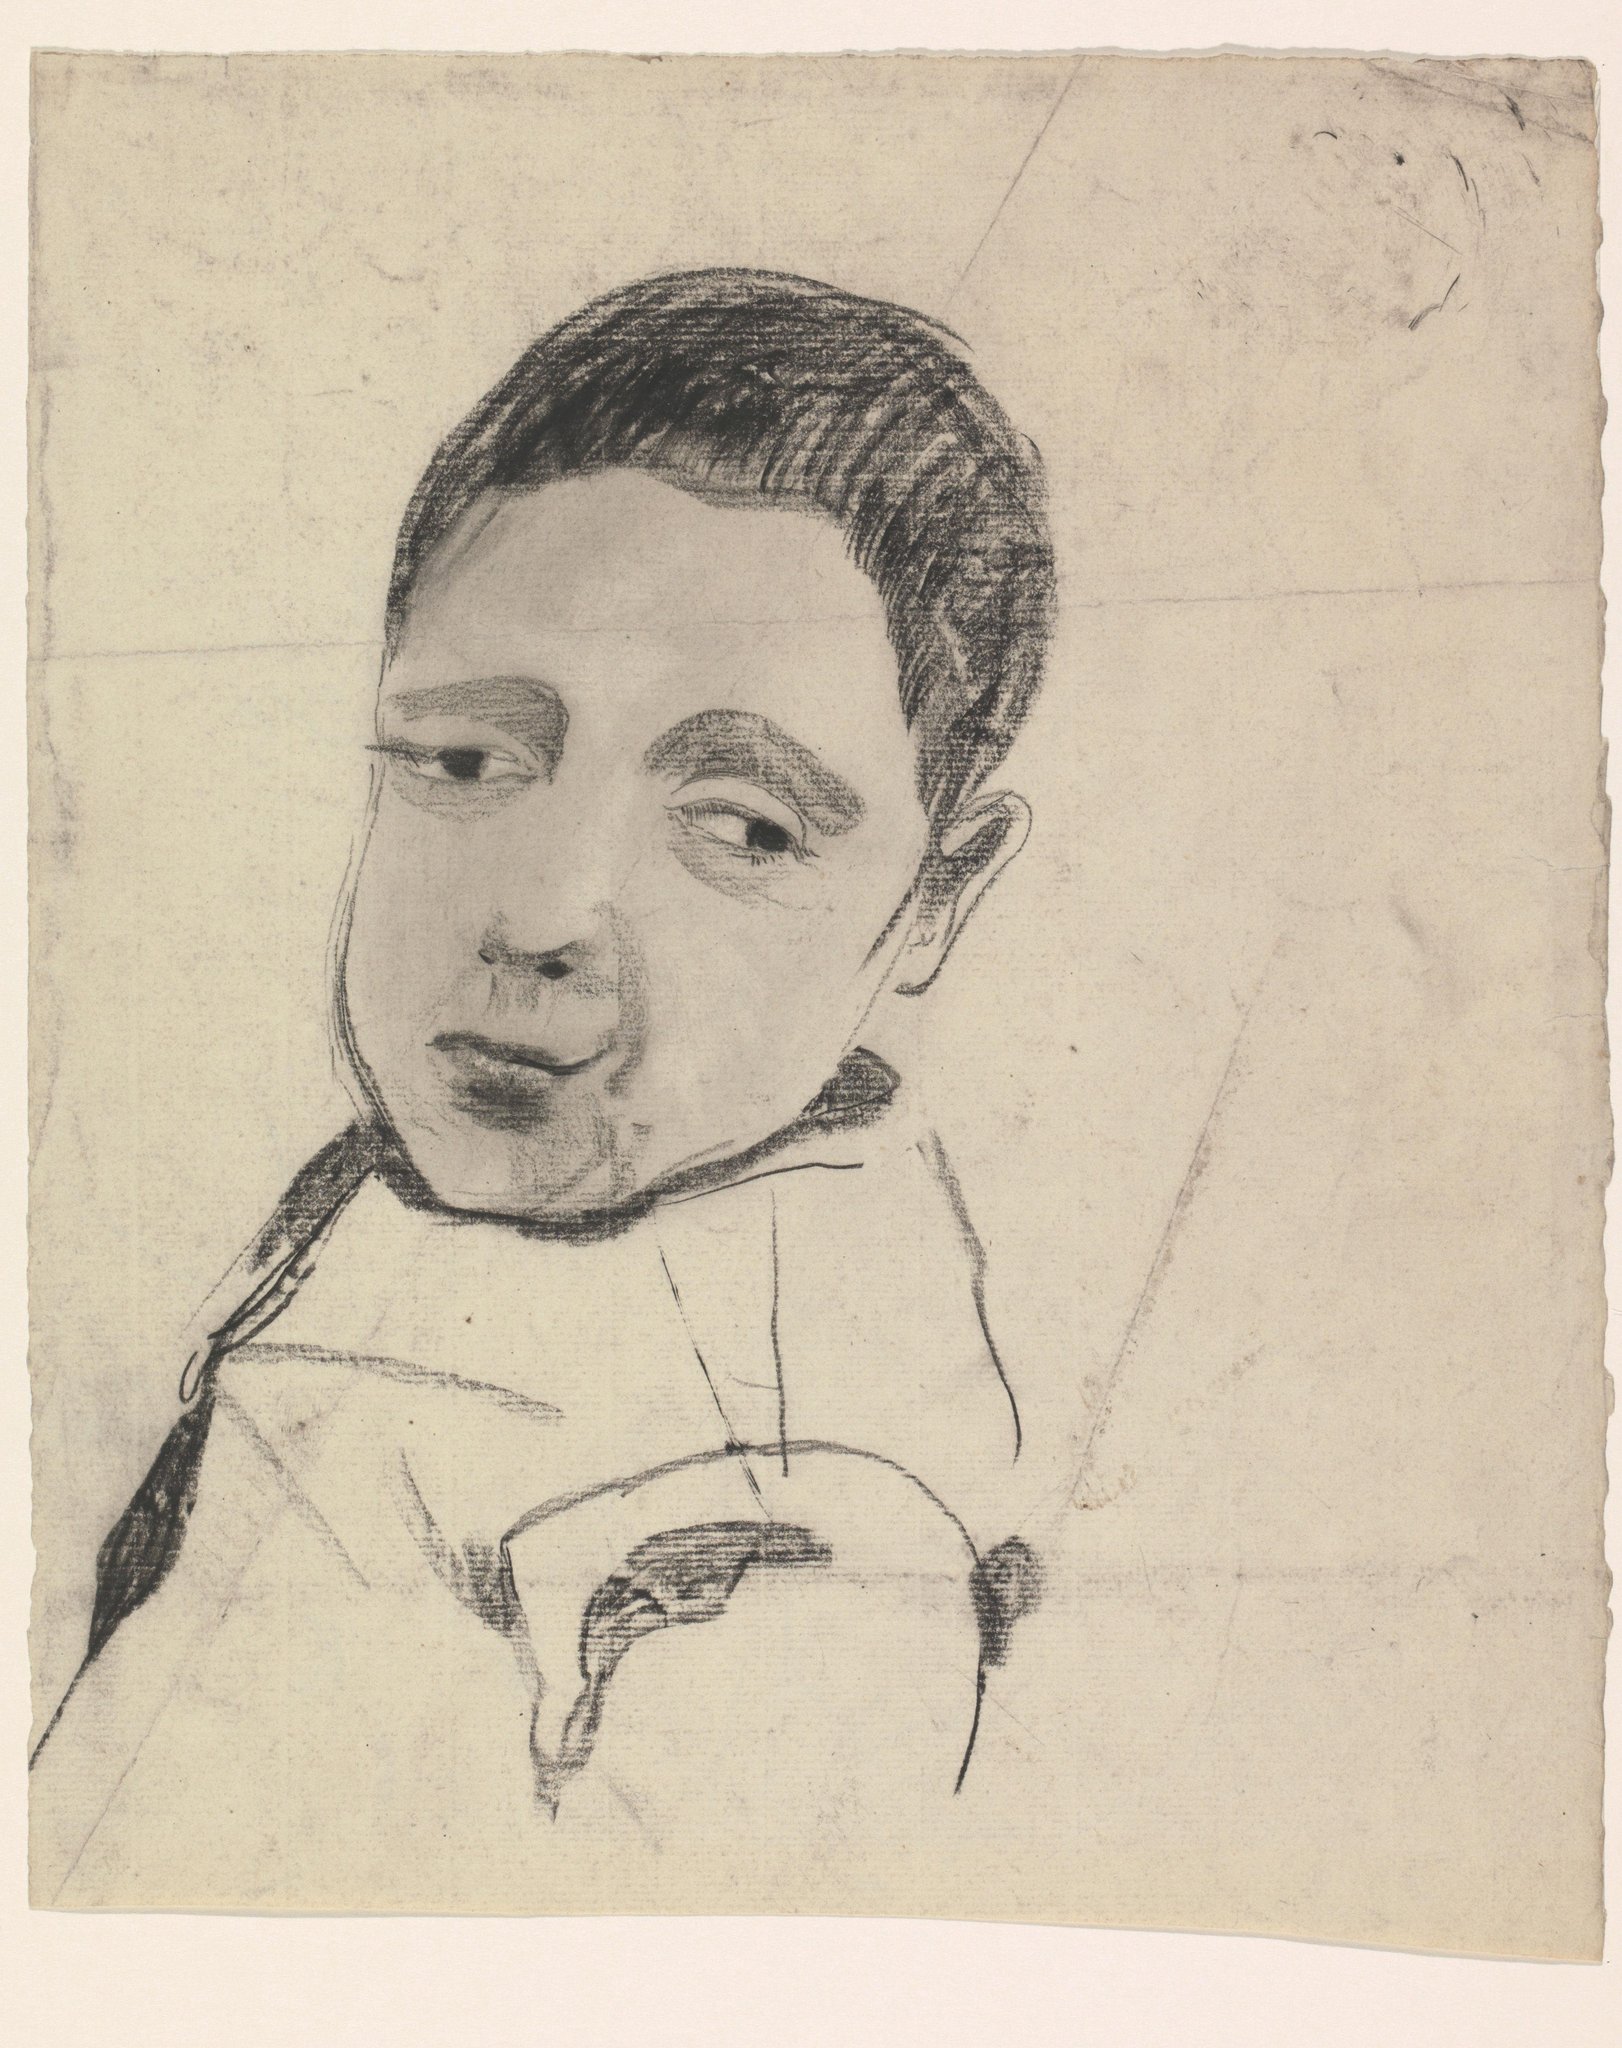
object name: drawing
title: Studie van een jongen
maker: carel adolph lion cachet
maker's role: draughtsman, print maker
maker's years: 1864-1945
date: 1874-1945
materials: chalk, paper